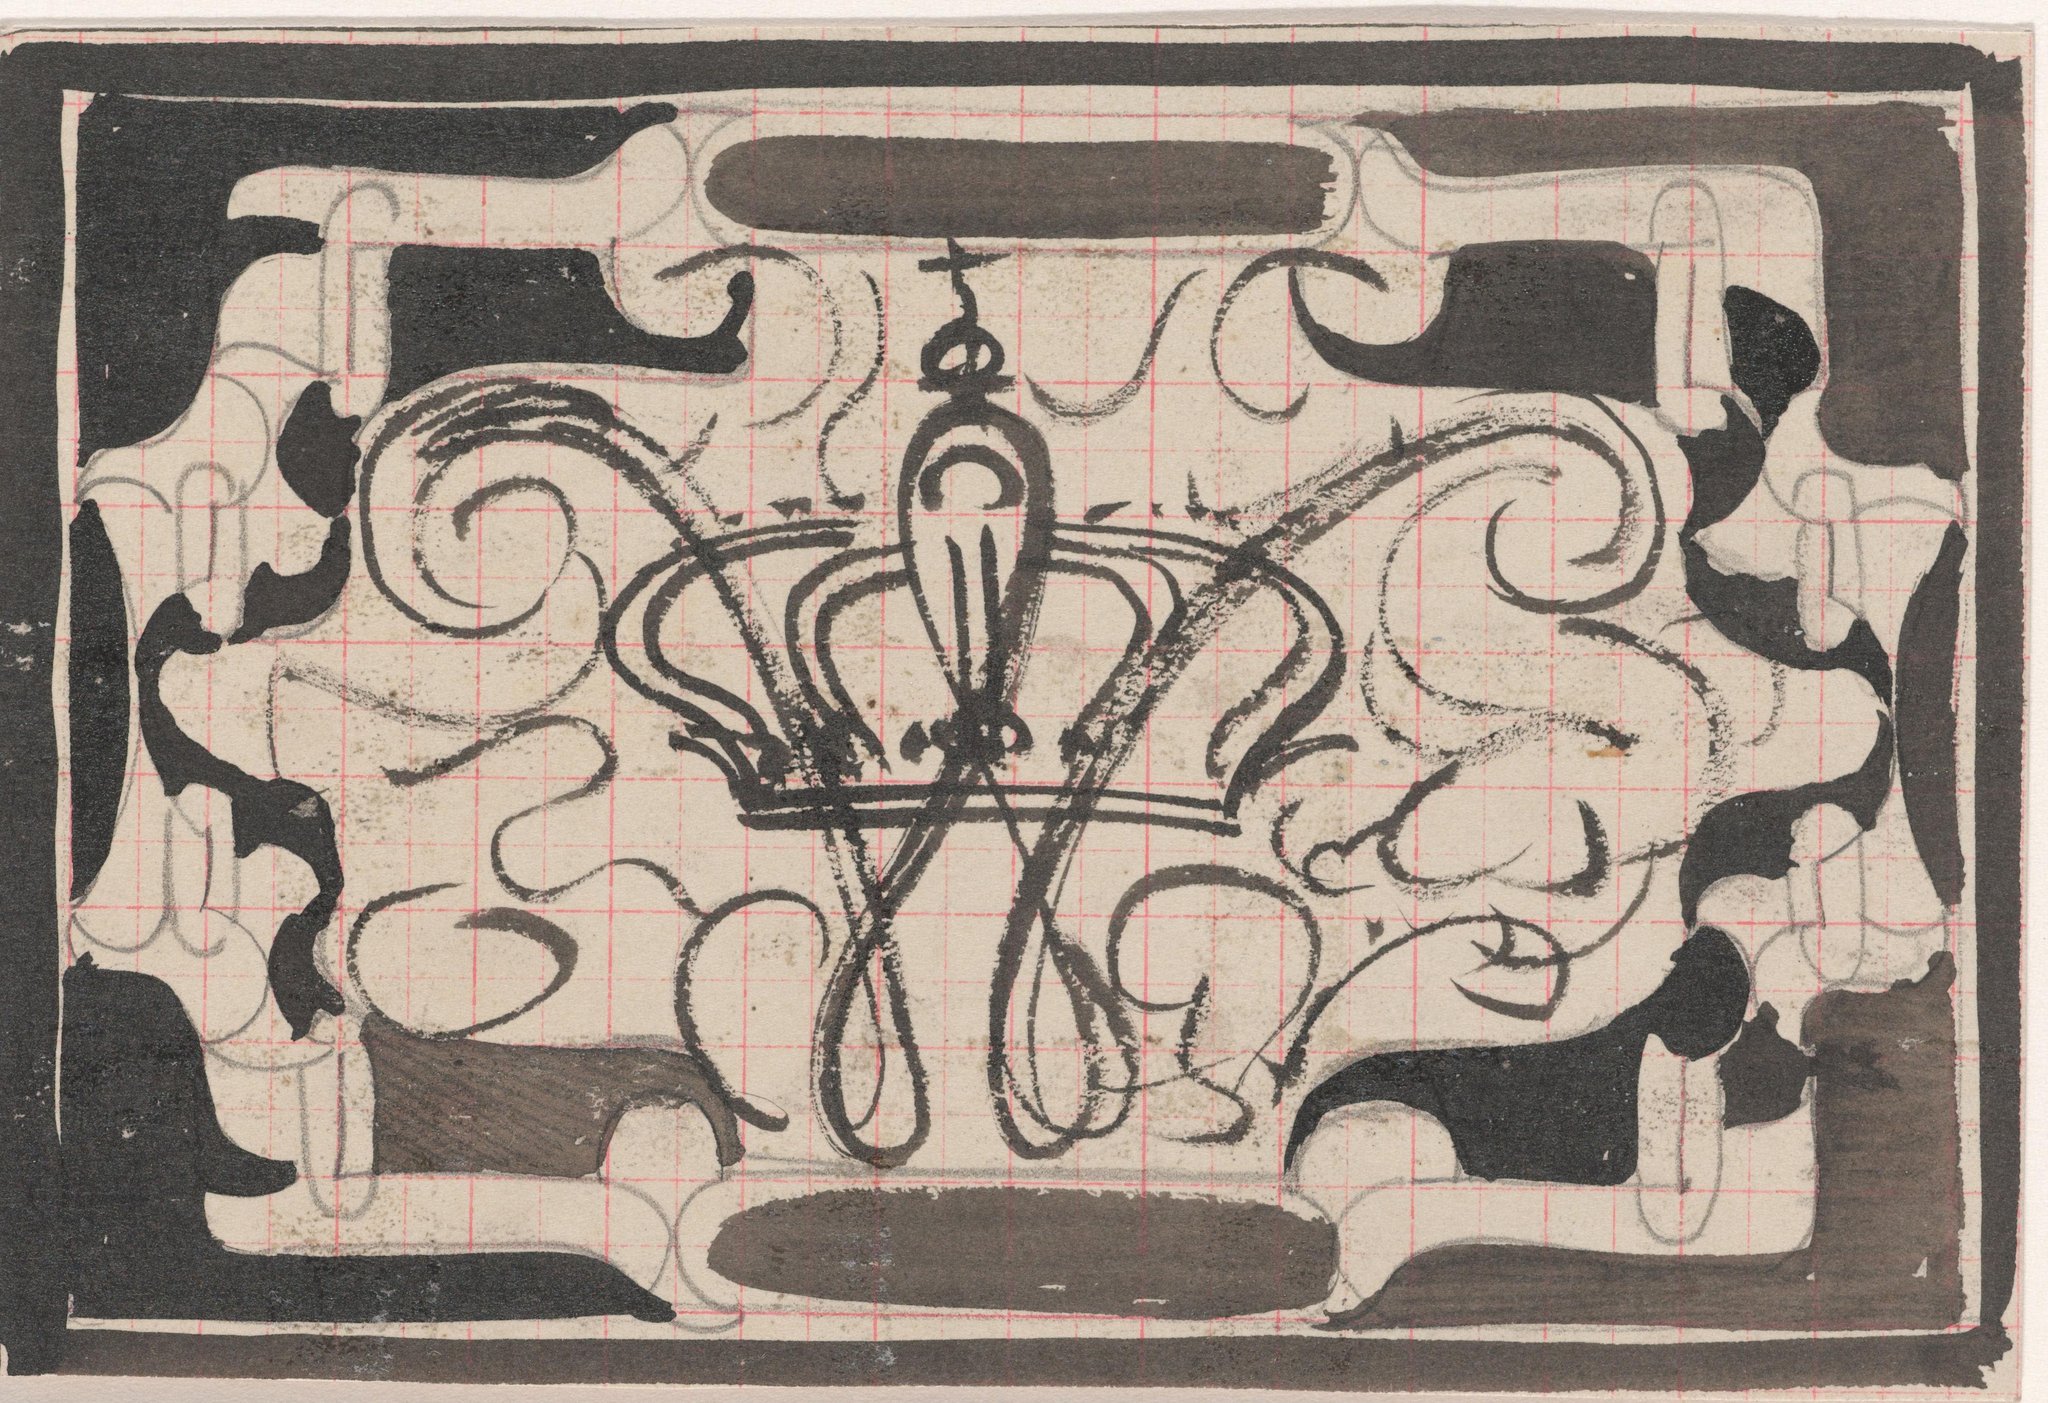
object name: drawing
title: Decoratief ontwerp met gekroonde W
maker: carel adolph lion cachet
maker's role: draughtsman, print maker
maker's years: 1864-1945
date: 1874-1945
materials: pencil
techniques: brush